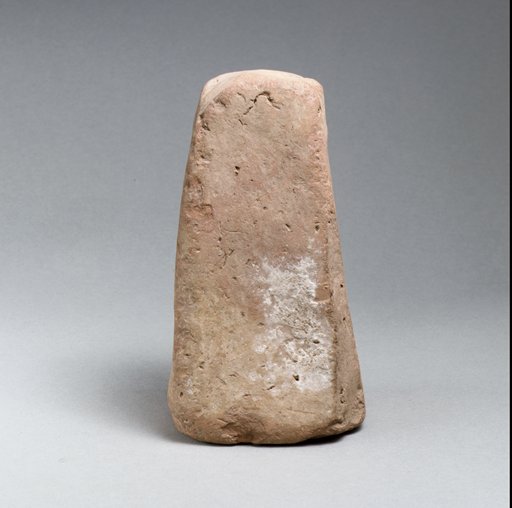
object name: loom weight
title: Terracotta loom weight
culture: greek or lydian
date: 900-30 BCE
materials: terracotta